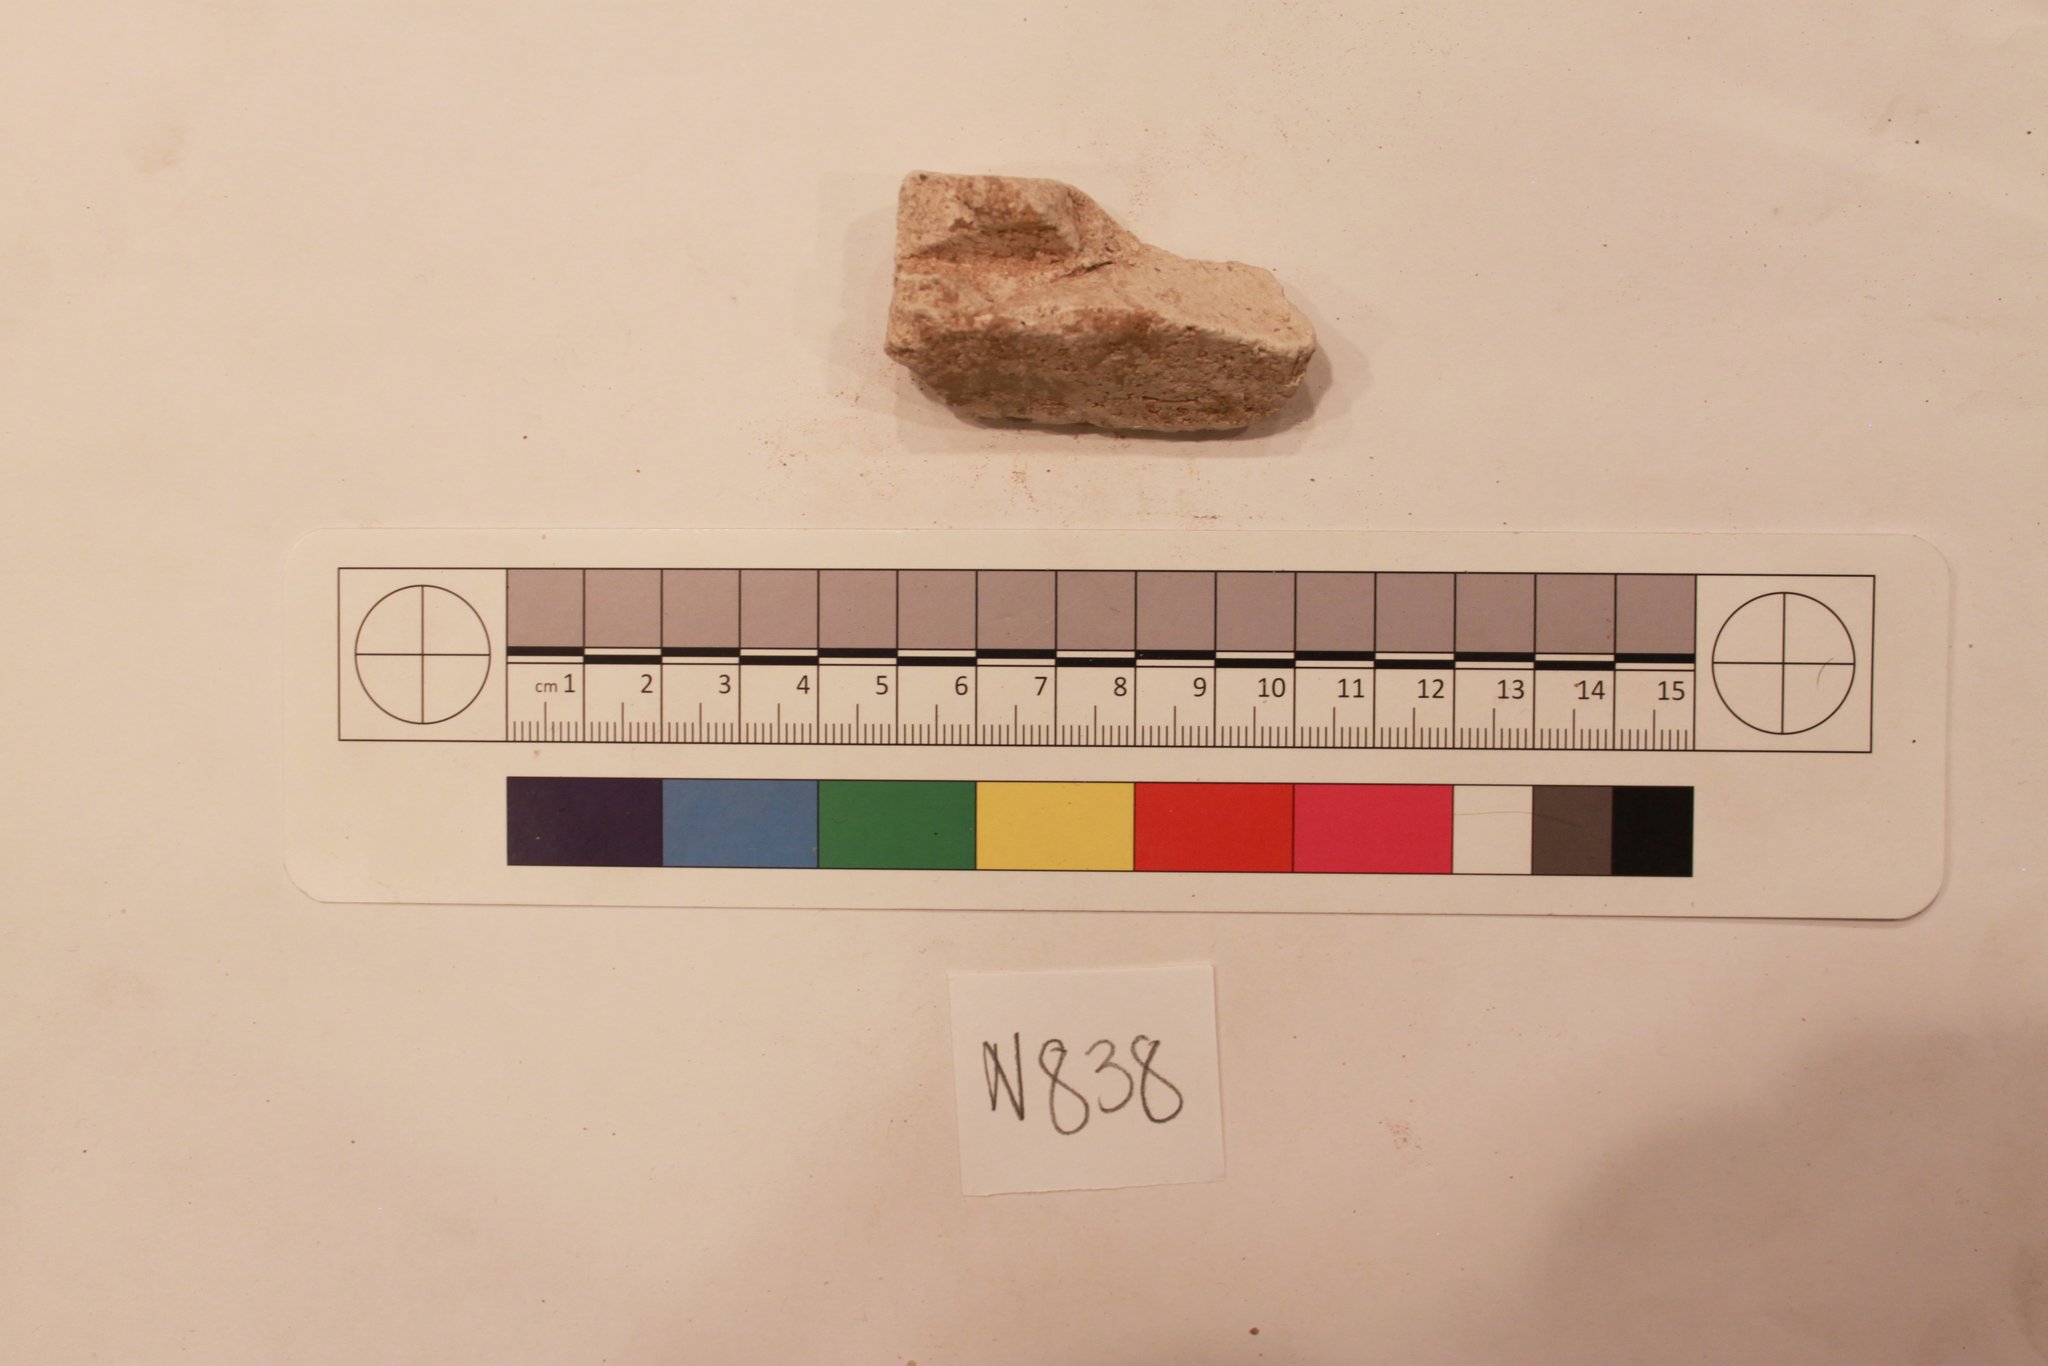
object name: fragment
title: Stucco Fragment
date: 701-1200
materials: plaster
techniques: carving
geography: iran